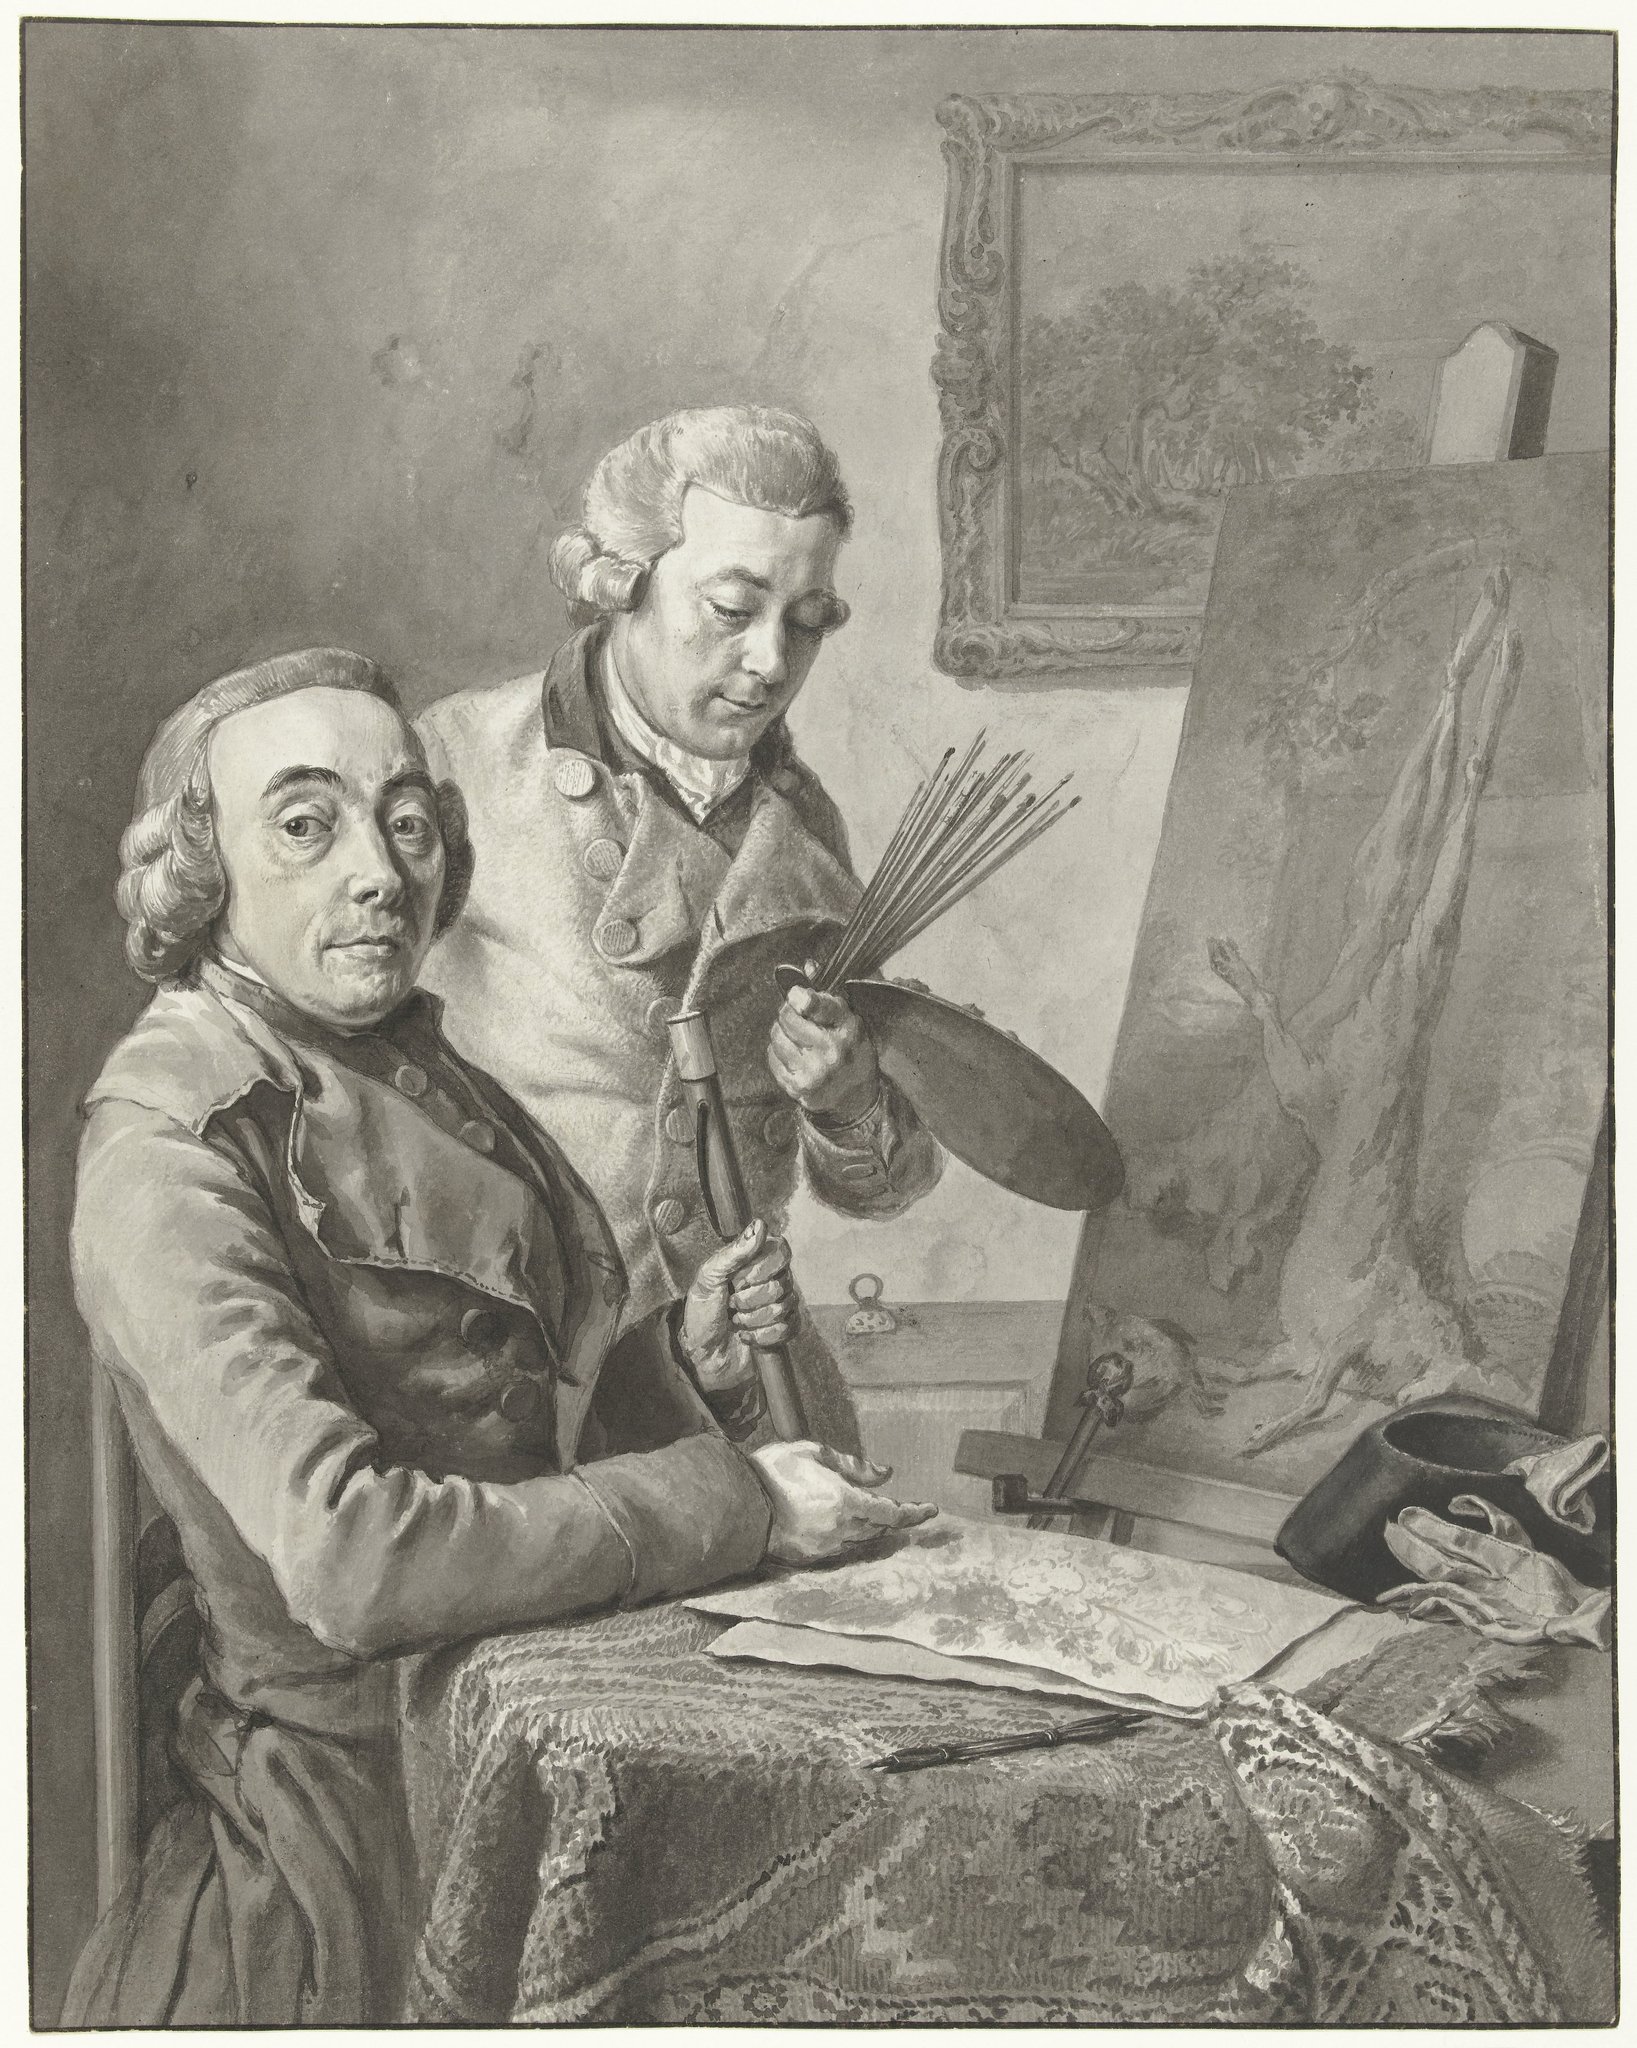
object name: drawing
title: Portret van Jacob de Vos I en de schilder Wybrand Hendriks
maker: wybrand hendriks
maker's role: draughtsman, painter, print maker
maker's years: 1744-1831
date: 1783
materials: chalk, ink, paper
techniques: brush, pen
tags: amsterdam, haarlem, painter, print maker, draughtsman, wybrand hendriks, jacob de vos (1735-1833), historical persons, portrait, self-portrait of painter, portrait, self-portrait of artist, patron (or client) visiting the artist